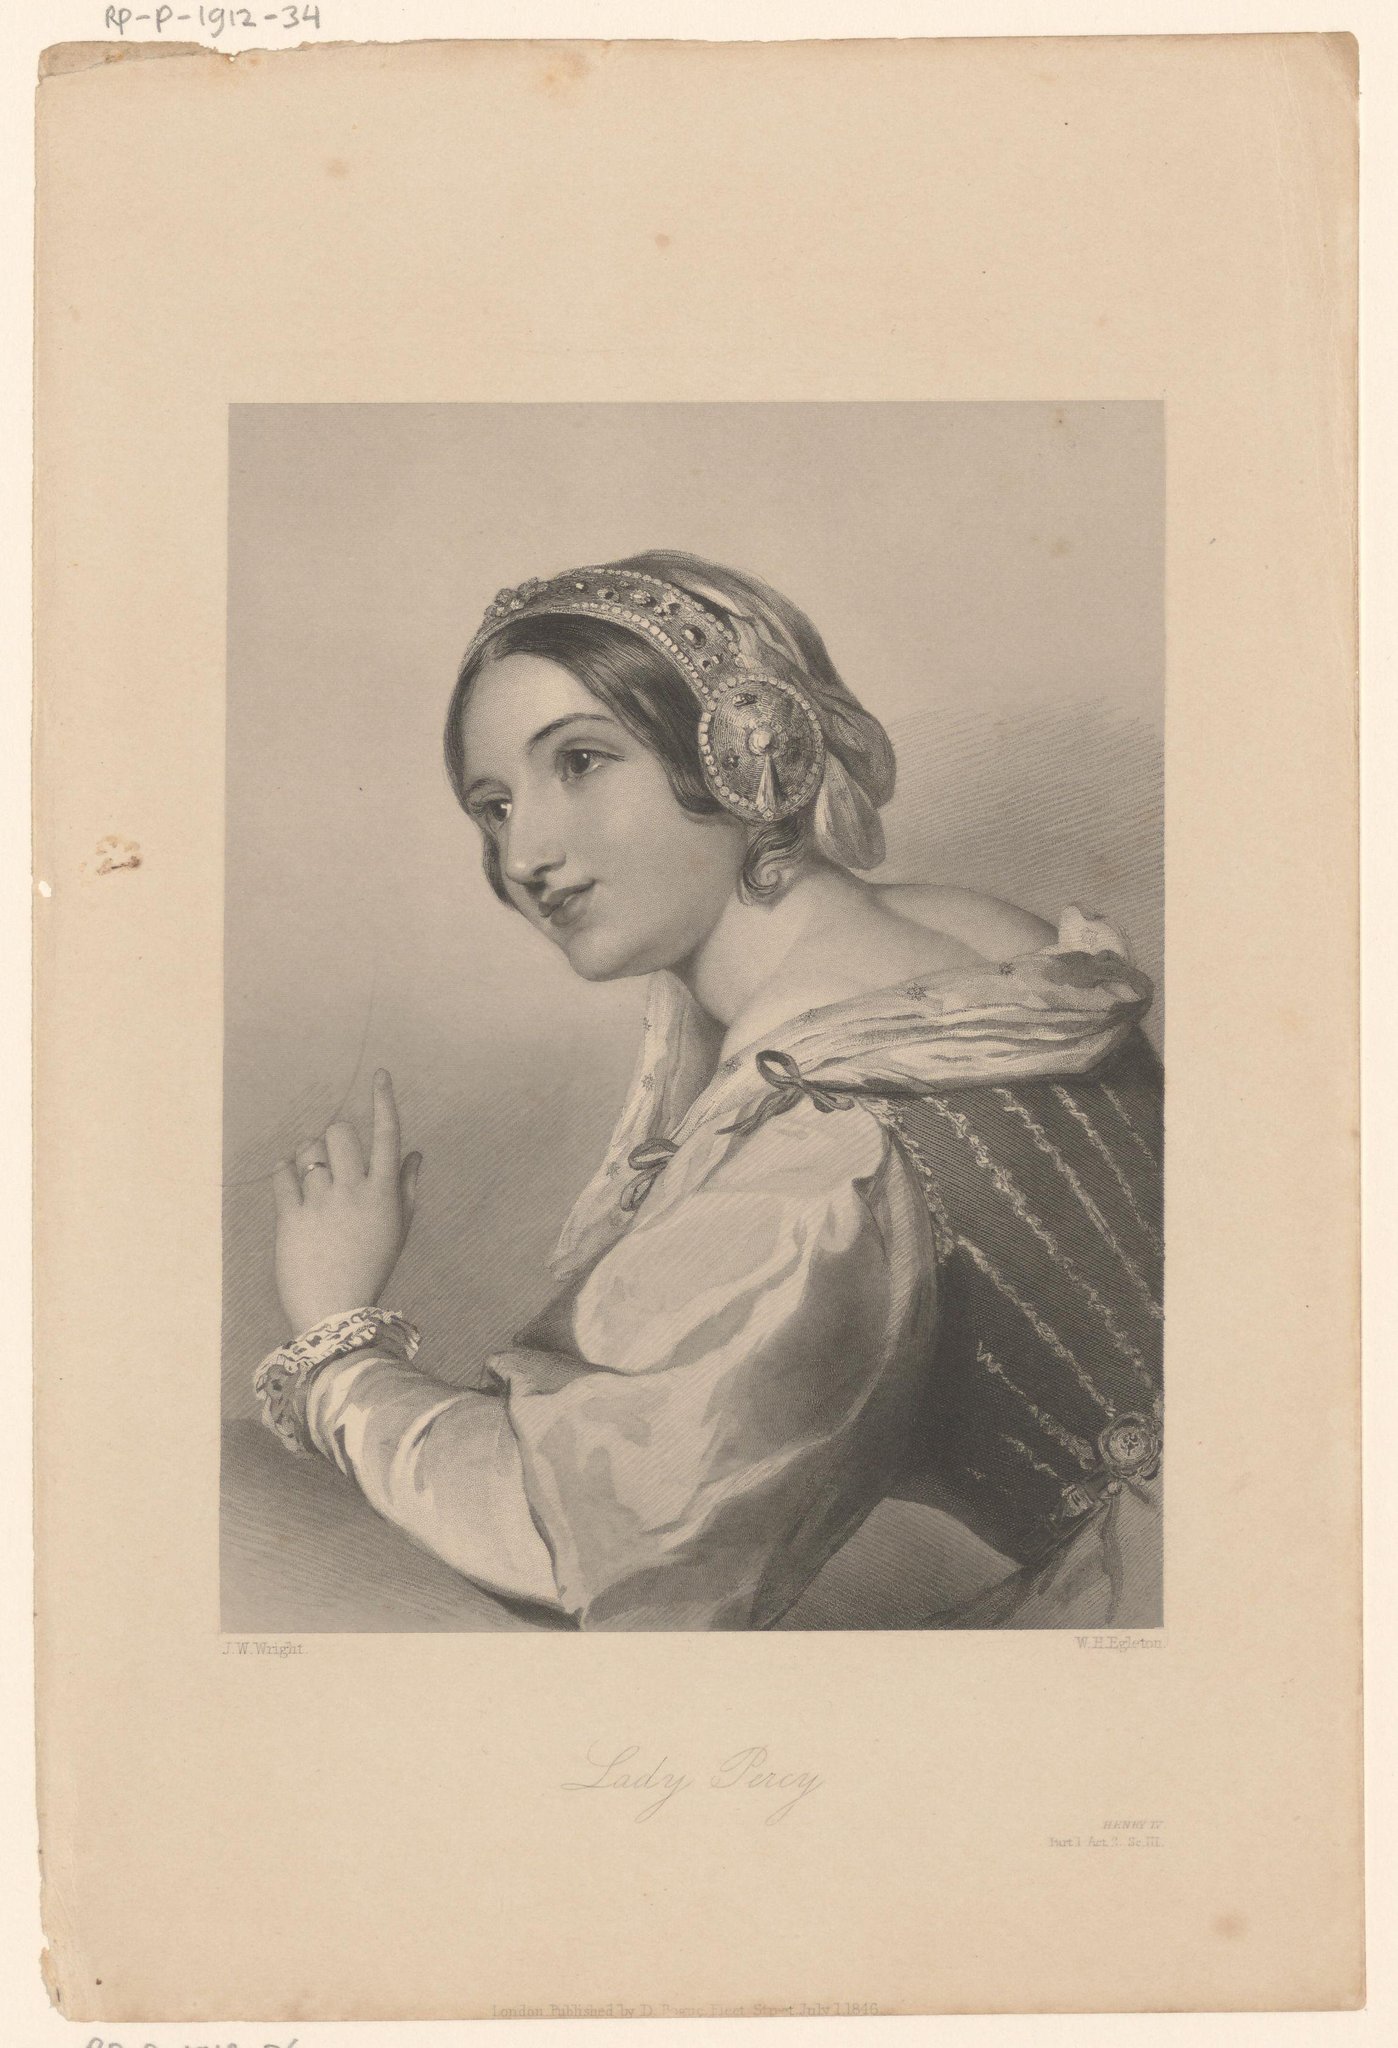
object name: book illustration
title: Lady Percy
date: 1807-1846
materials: paper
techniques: etching, roulette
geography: london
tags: william shakespeare, female literary characters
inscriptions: collector's mark: Lugt 2228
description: Prent ook gebruikt in: Heath, Charles. The heroines of Shakespeare: comprising the principal female characters in the plays of the great poet. Londen: David Bogue, 1848.